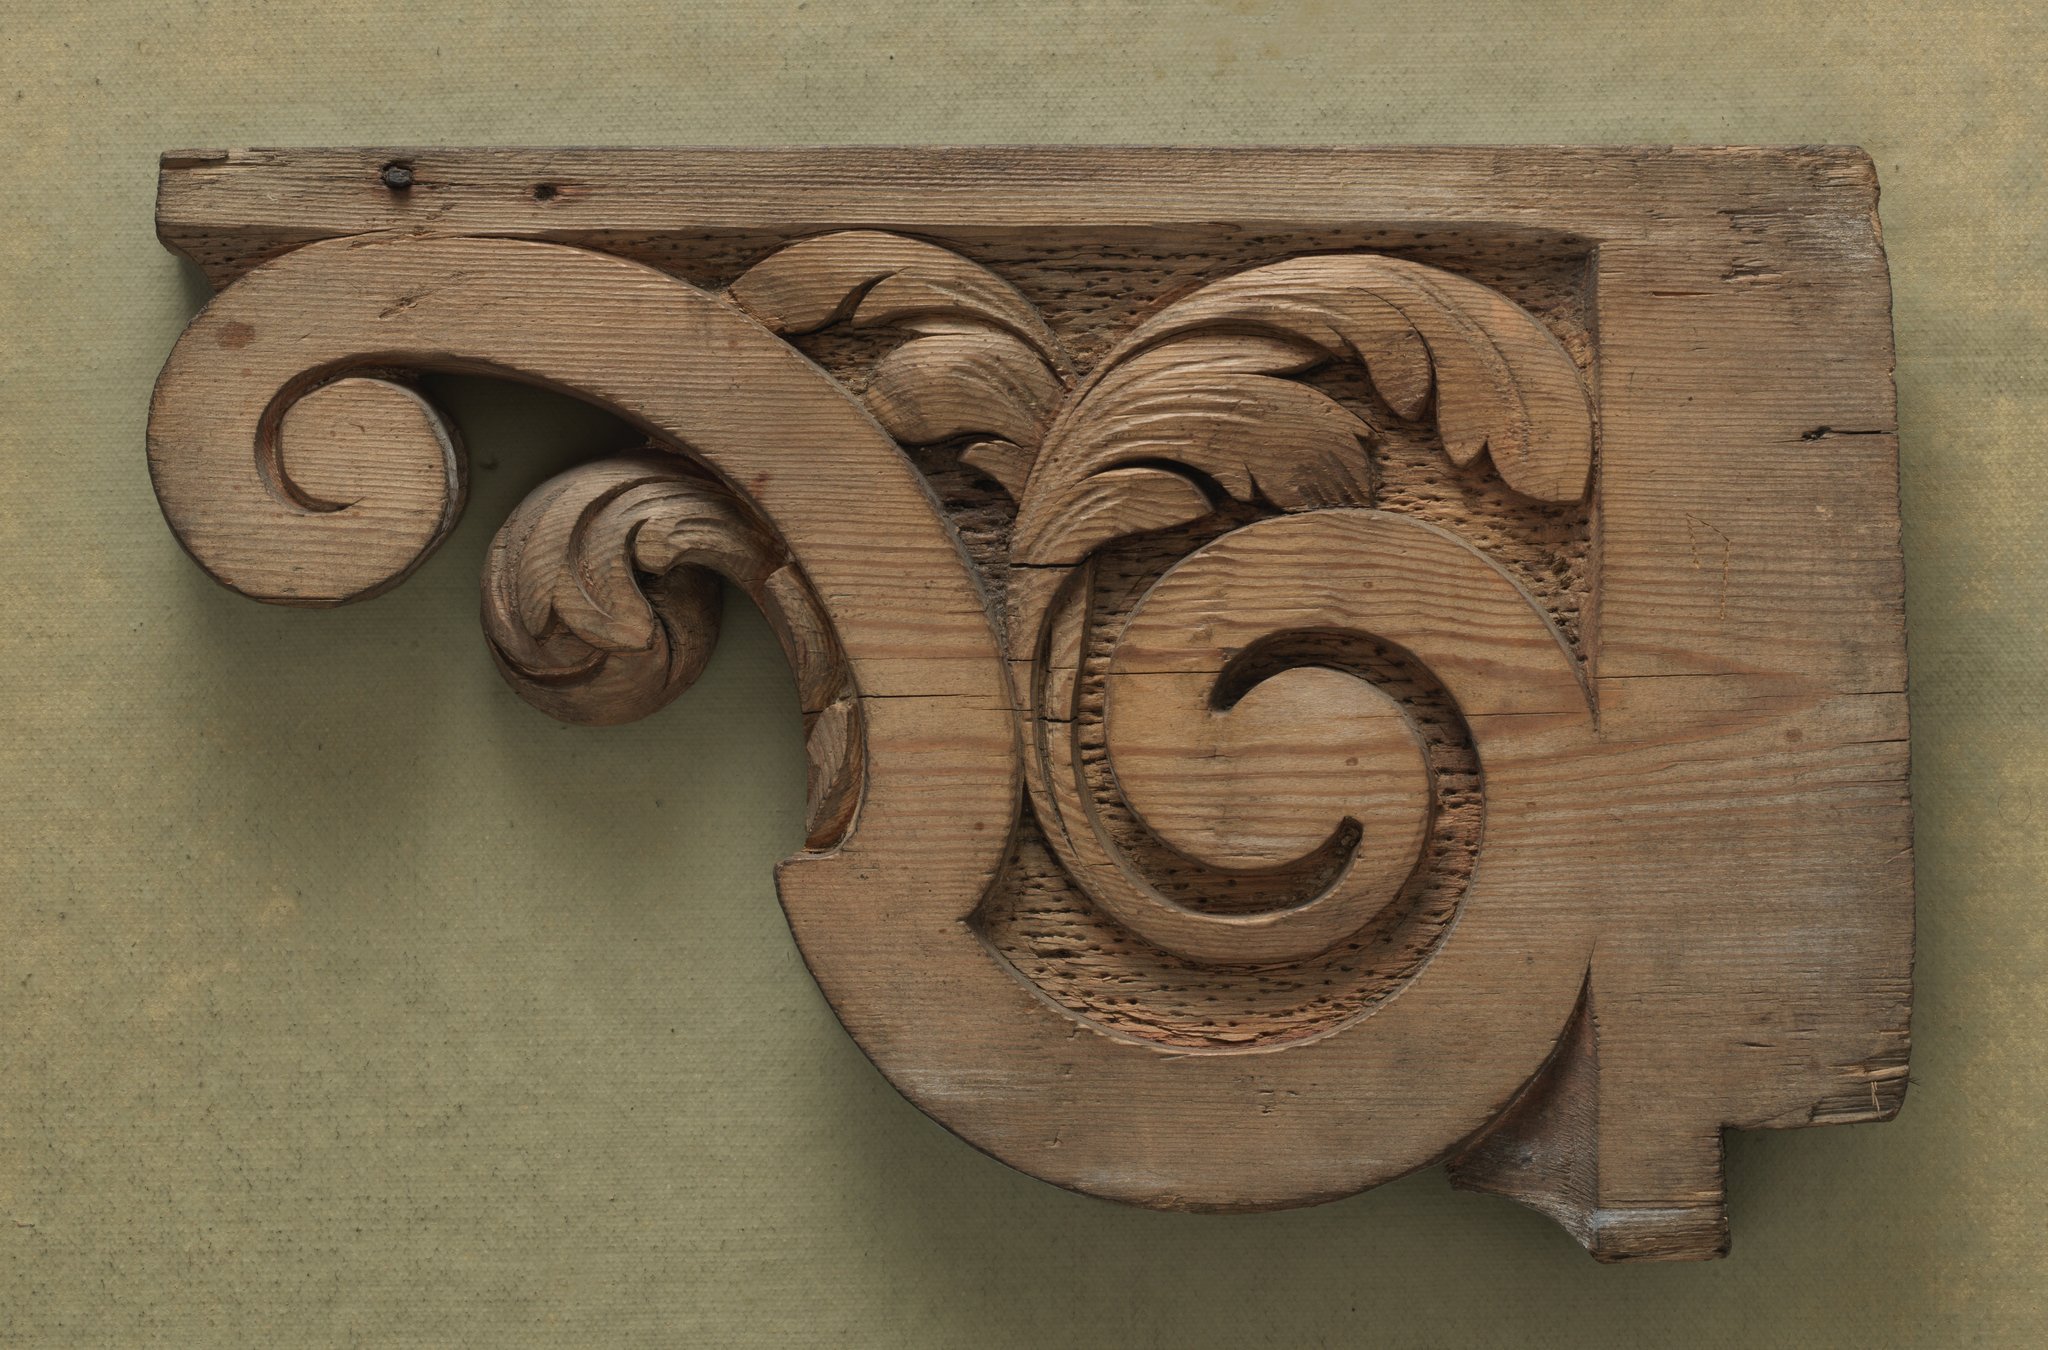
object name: bracket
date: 1701-1800